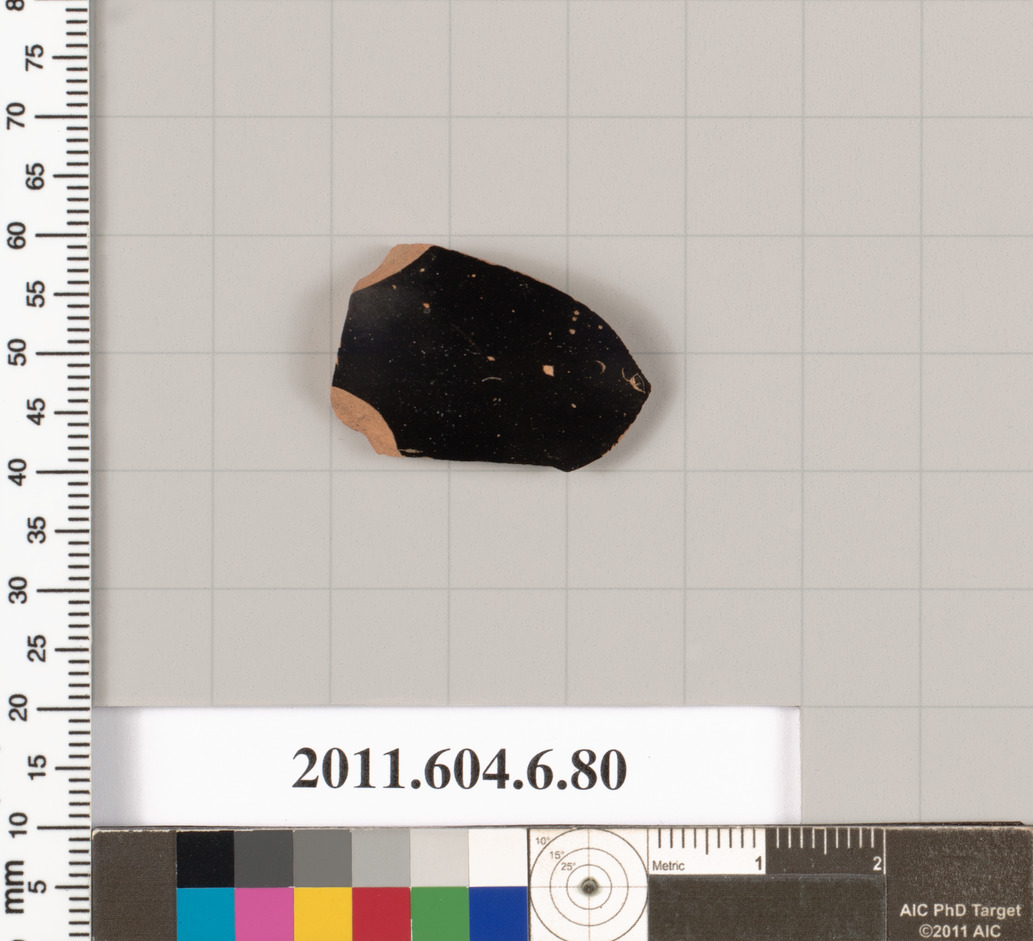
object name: undetermined open shape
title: Terracotta fragment of an open shape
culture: greek, attic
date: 600-401 BCE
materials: terracotta